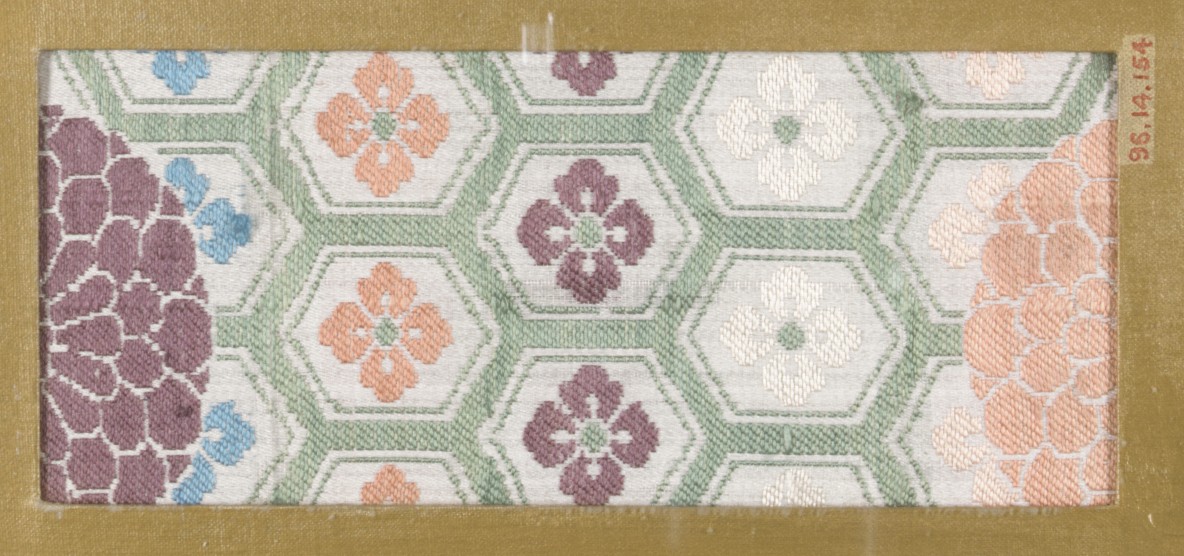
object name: fragment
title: Textile fragment with pattern of chrysanthemums on hexagonal lattice (Kikkō)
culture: japanese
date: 1701-1900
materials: silk